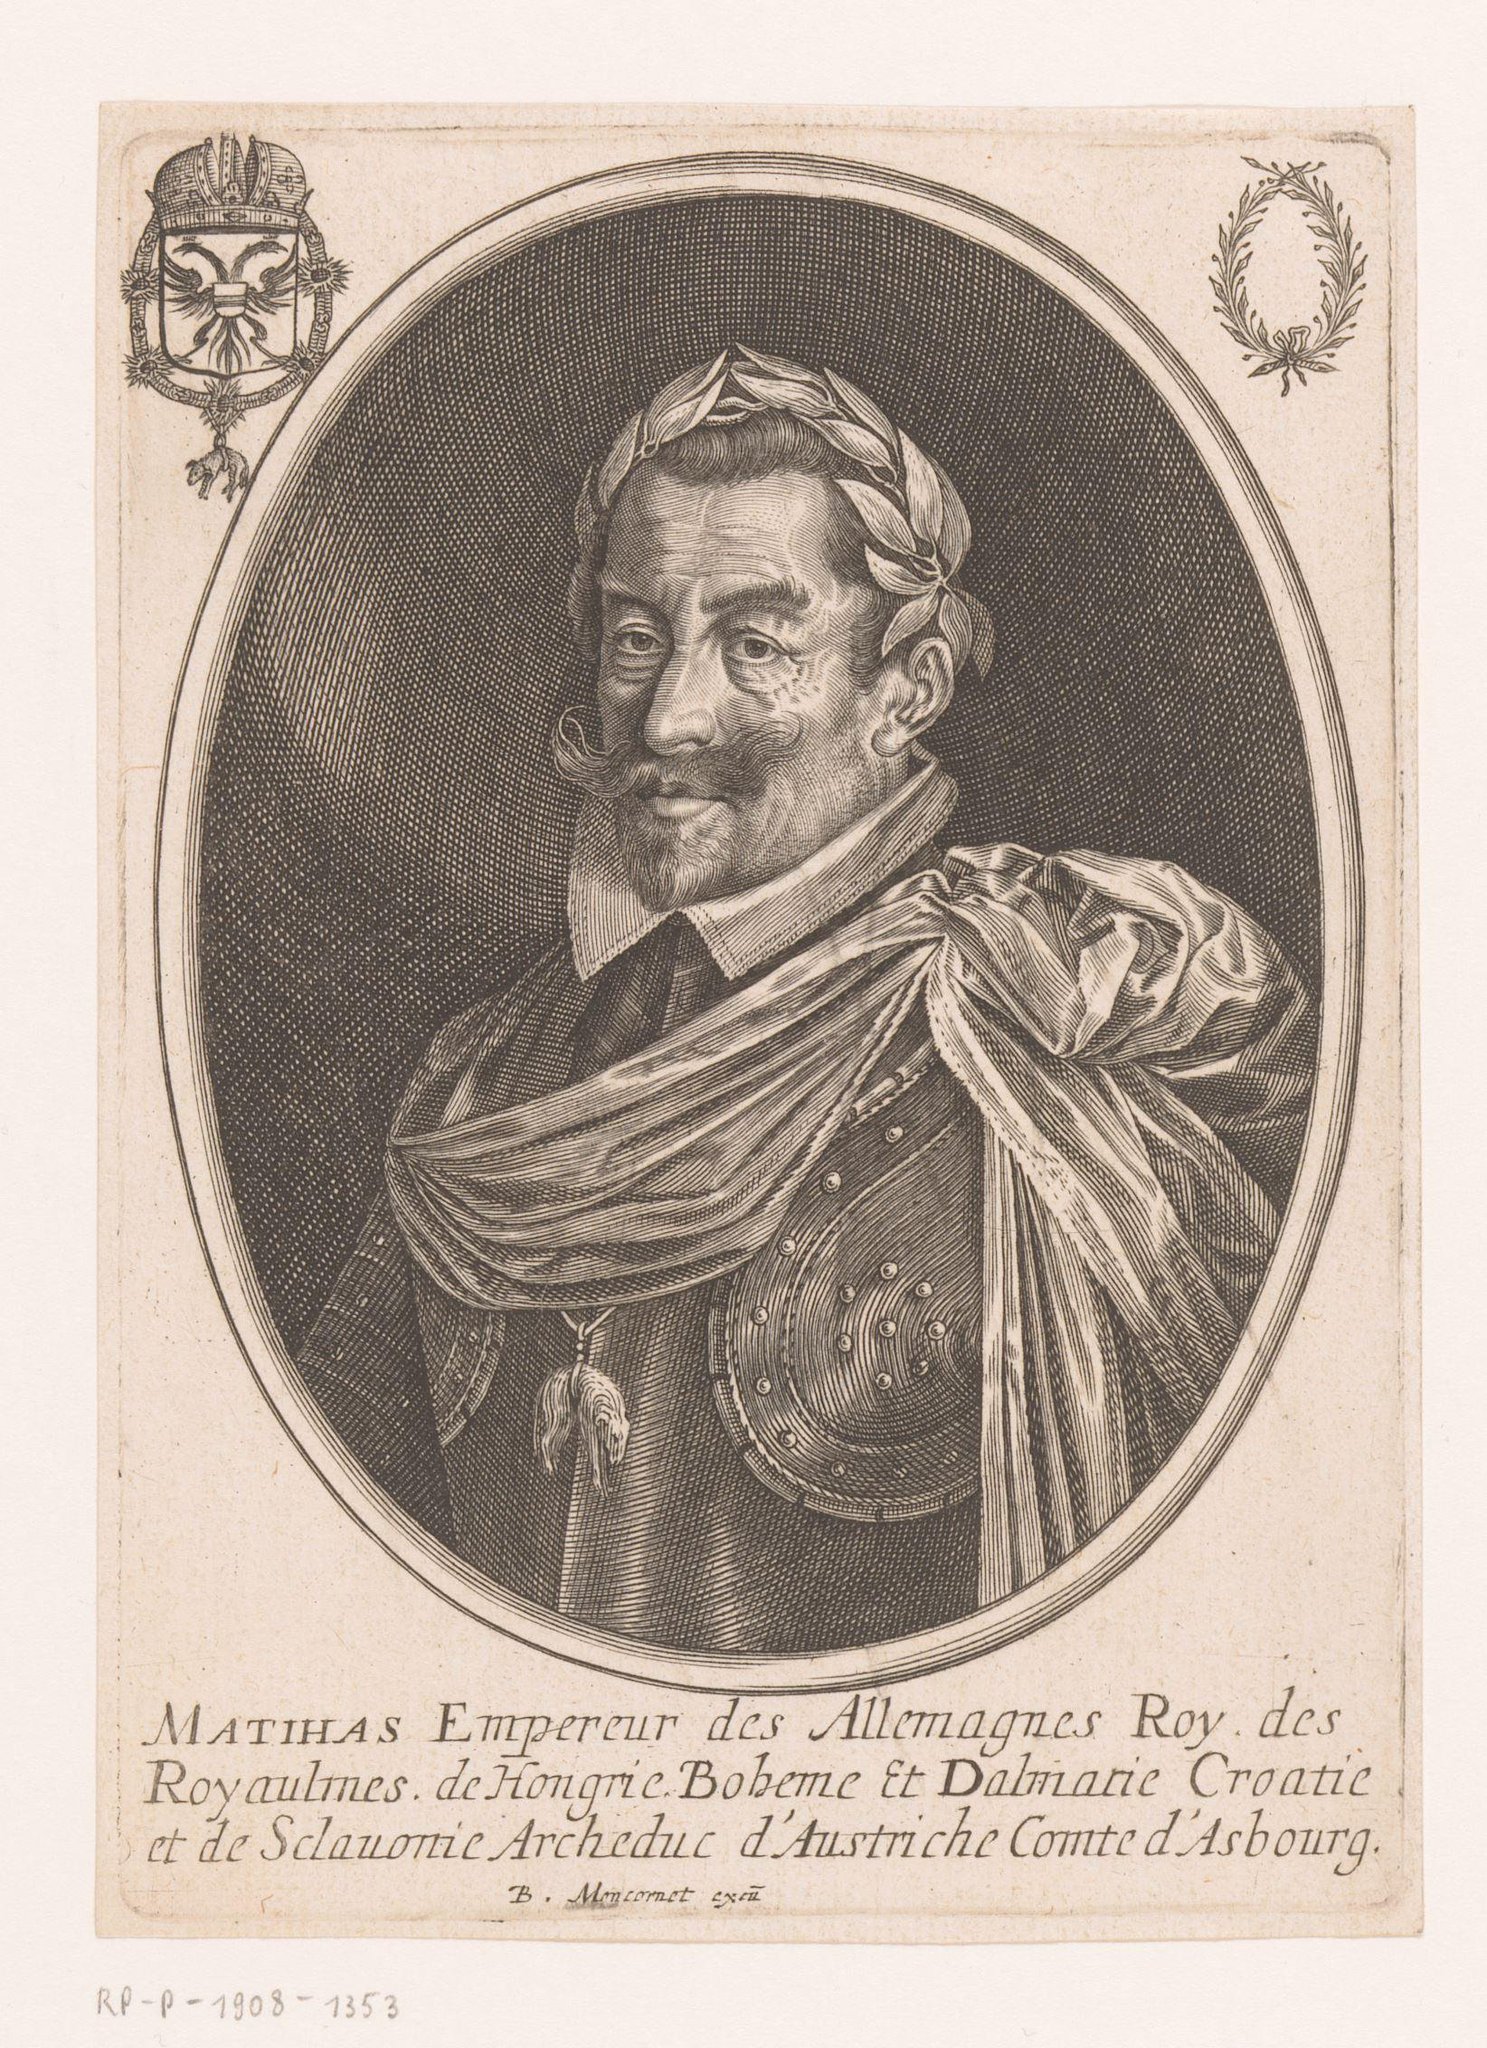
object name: print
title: Portret van keizer Matthias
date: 1610-1668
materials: paper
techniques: engraving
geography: paris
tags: matthias van oostenrijk (rooms-duits keizer), historical persons, emperor, armorial bearing, heraldry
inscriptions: collector's mark: Lugt 2228